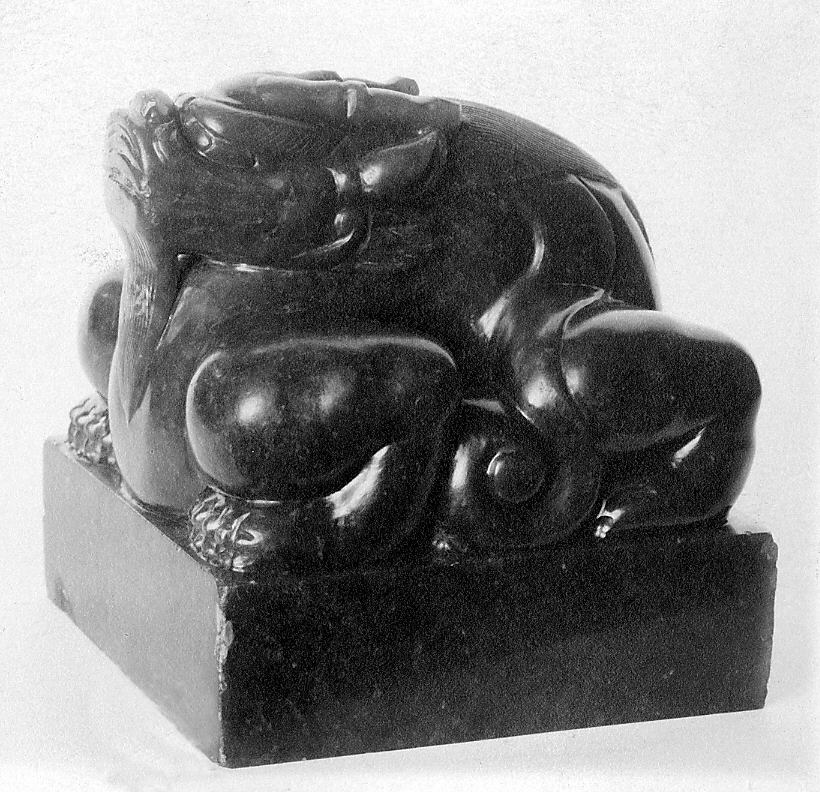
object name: seal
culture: chinese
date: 960-1279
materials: jade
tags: animals